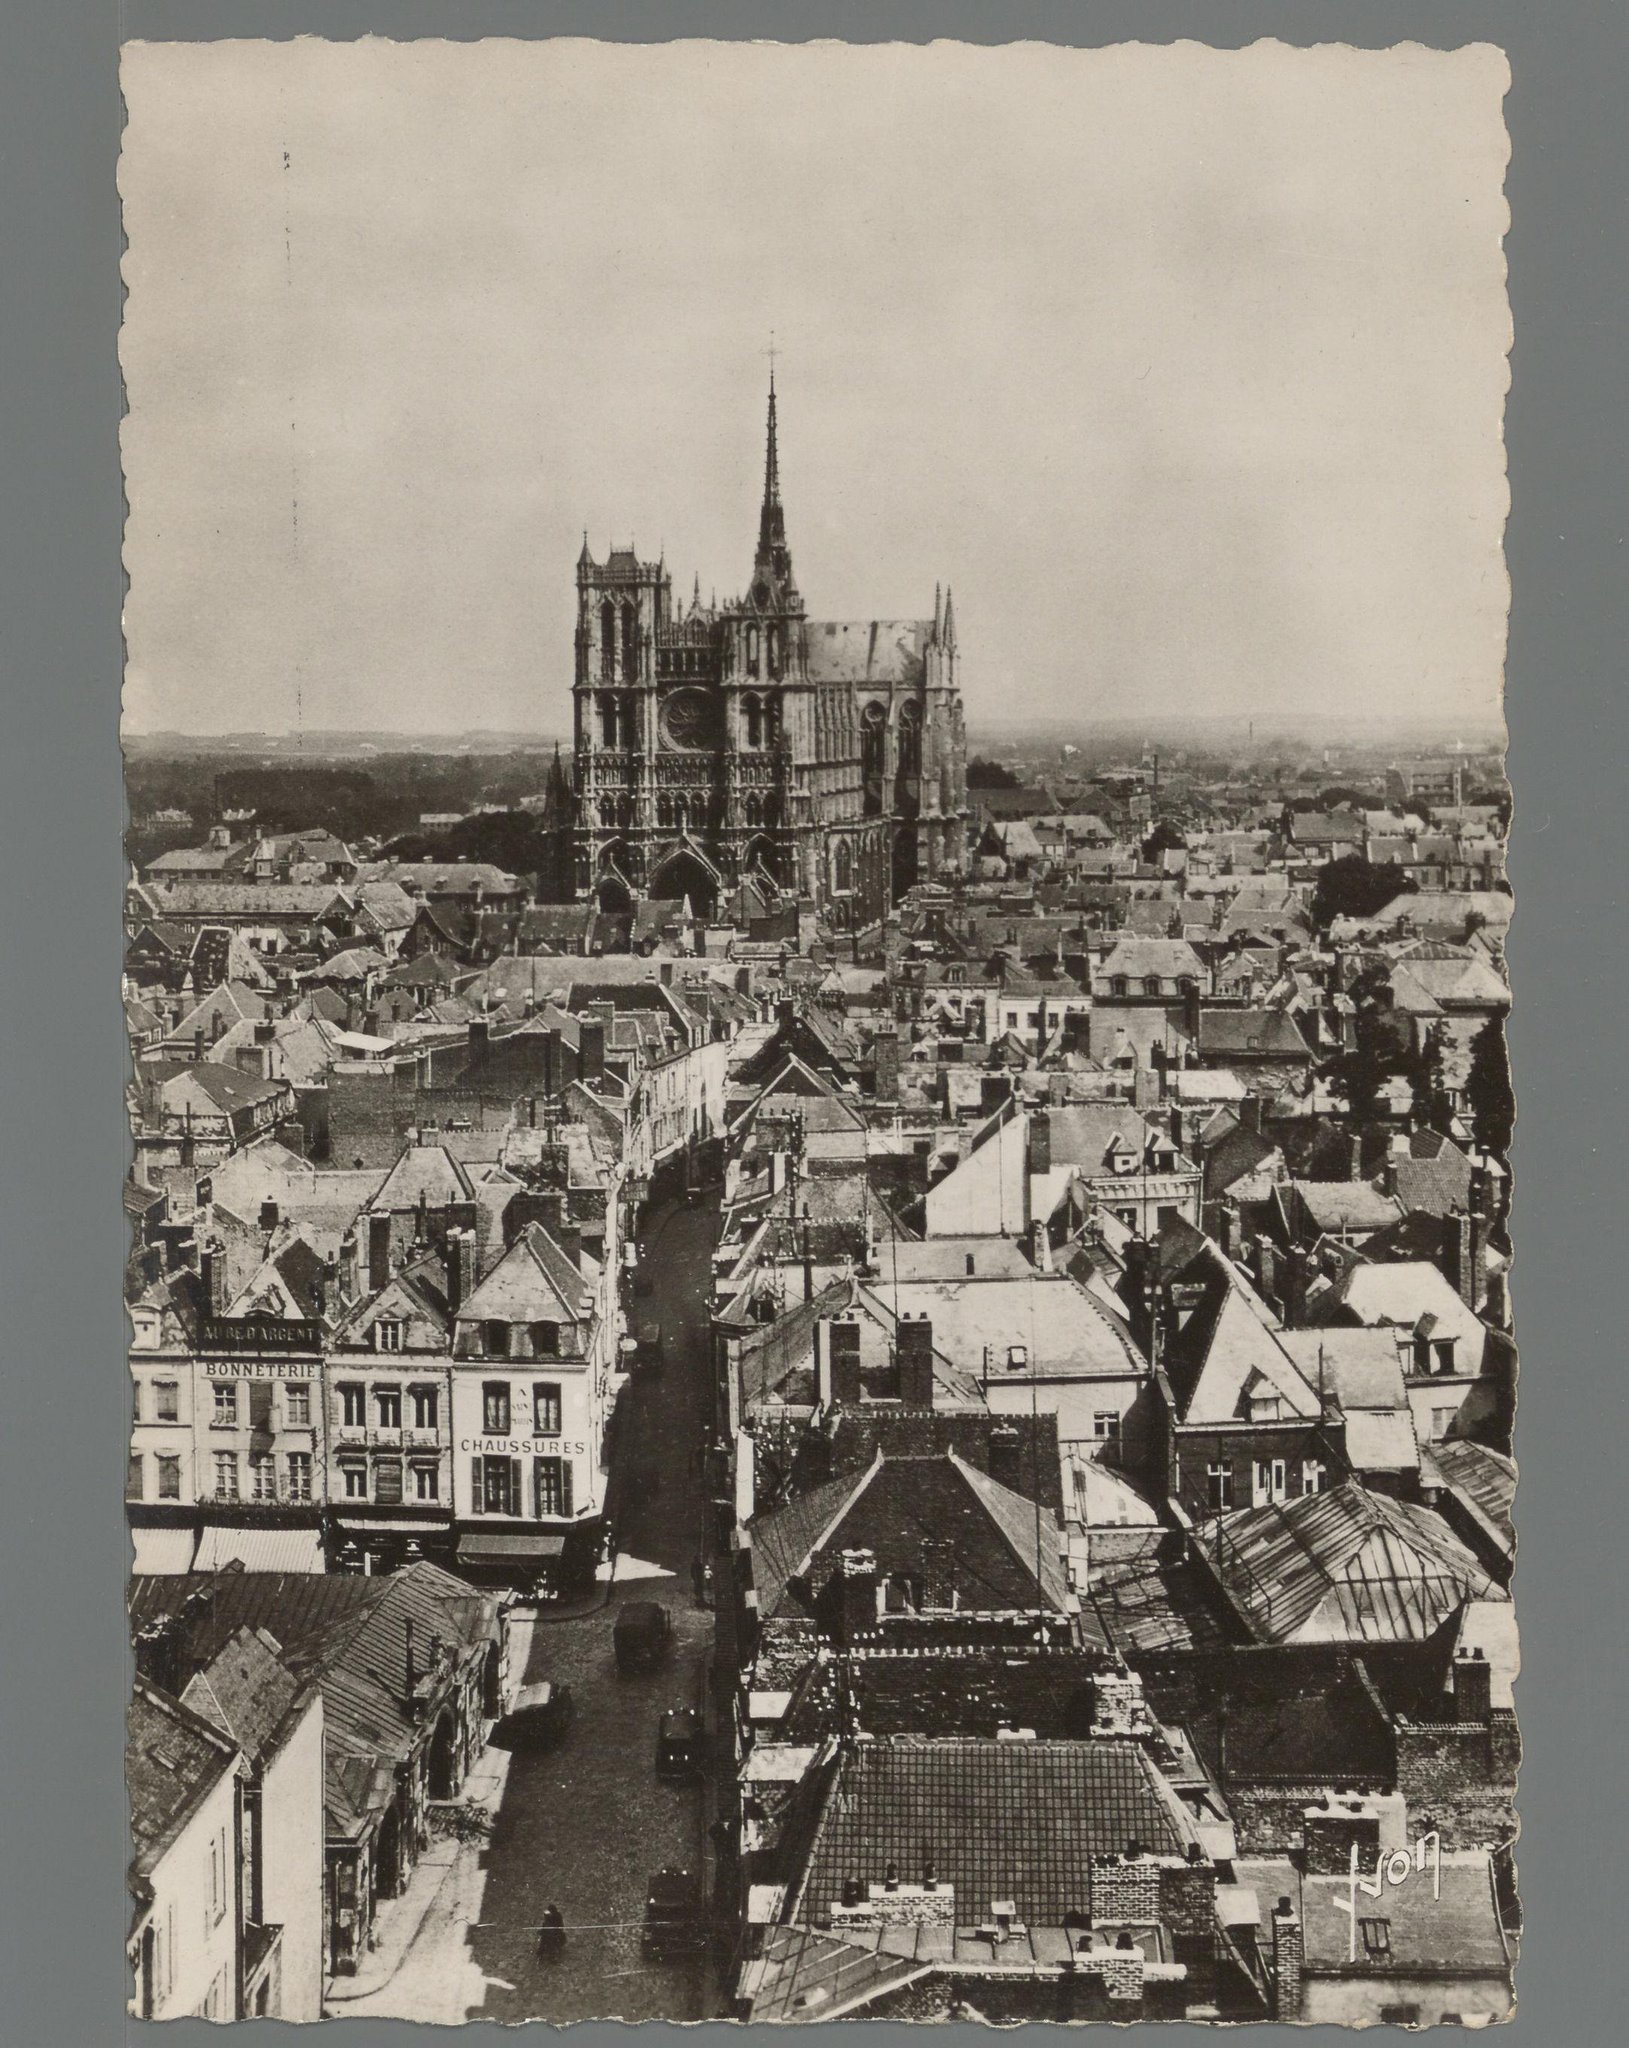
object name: photograph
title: Amiens (Somme). La Cathédrale vue du Beffroi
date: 1930-1950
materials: photographic support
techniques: photography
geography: paris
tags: city-view, and landscape with man-made constructions, church (exterior), notre-dame d'amiens